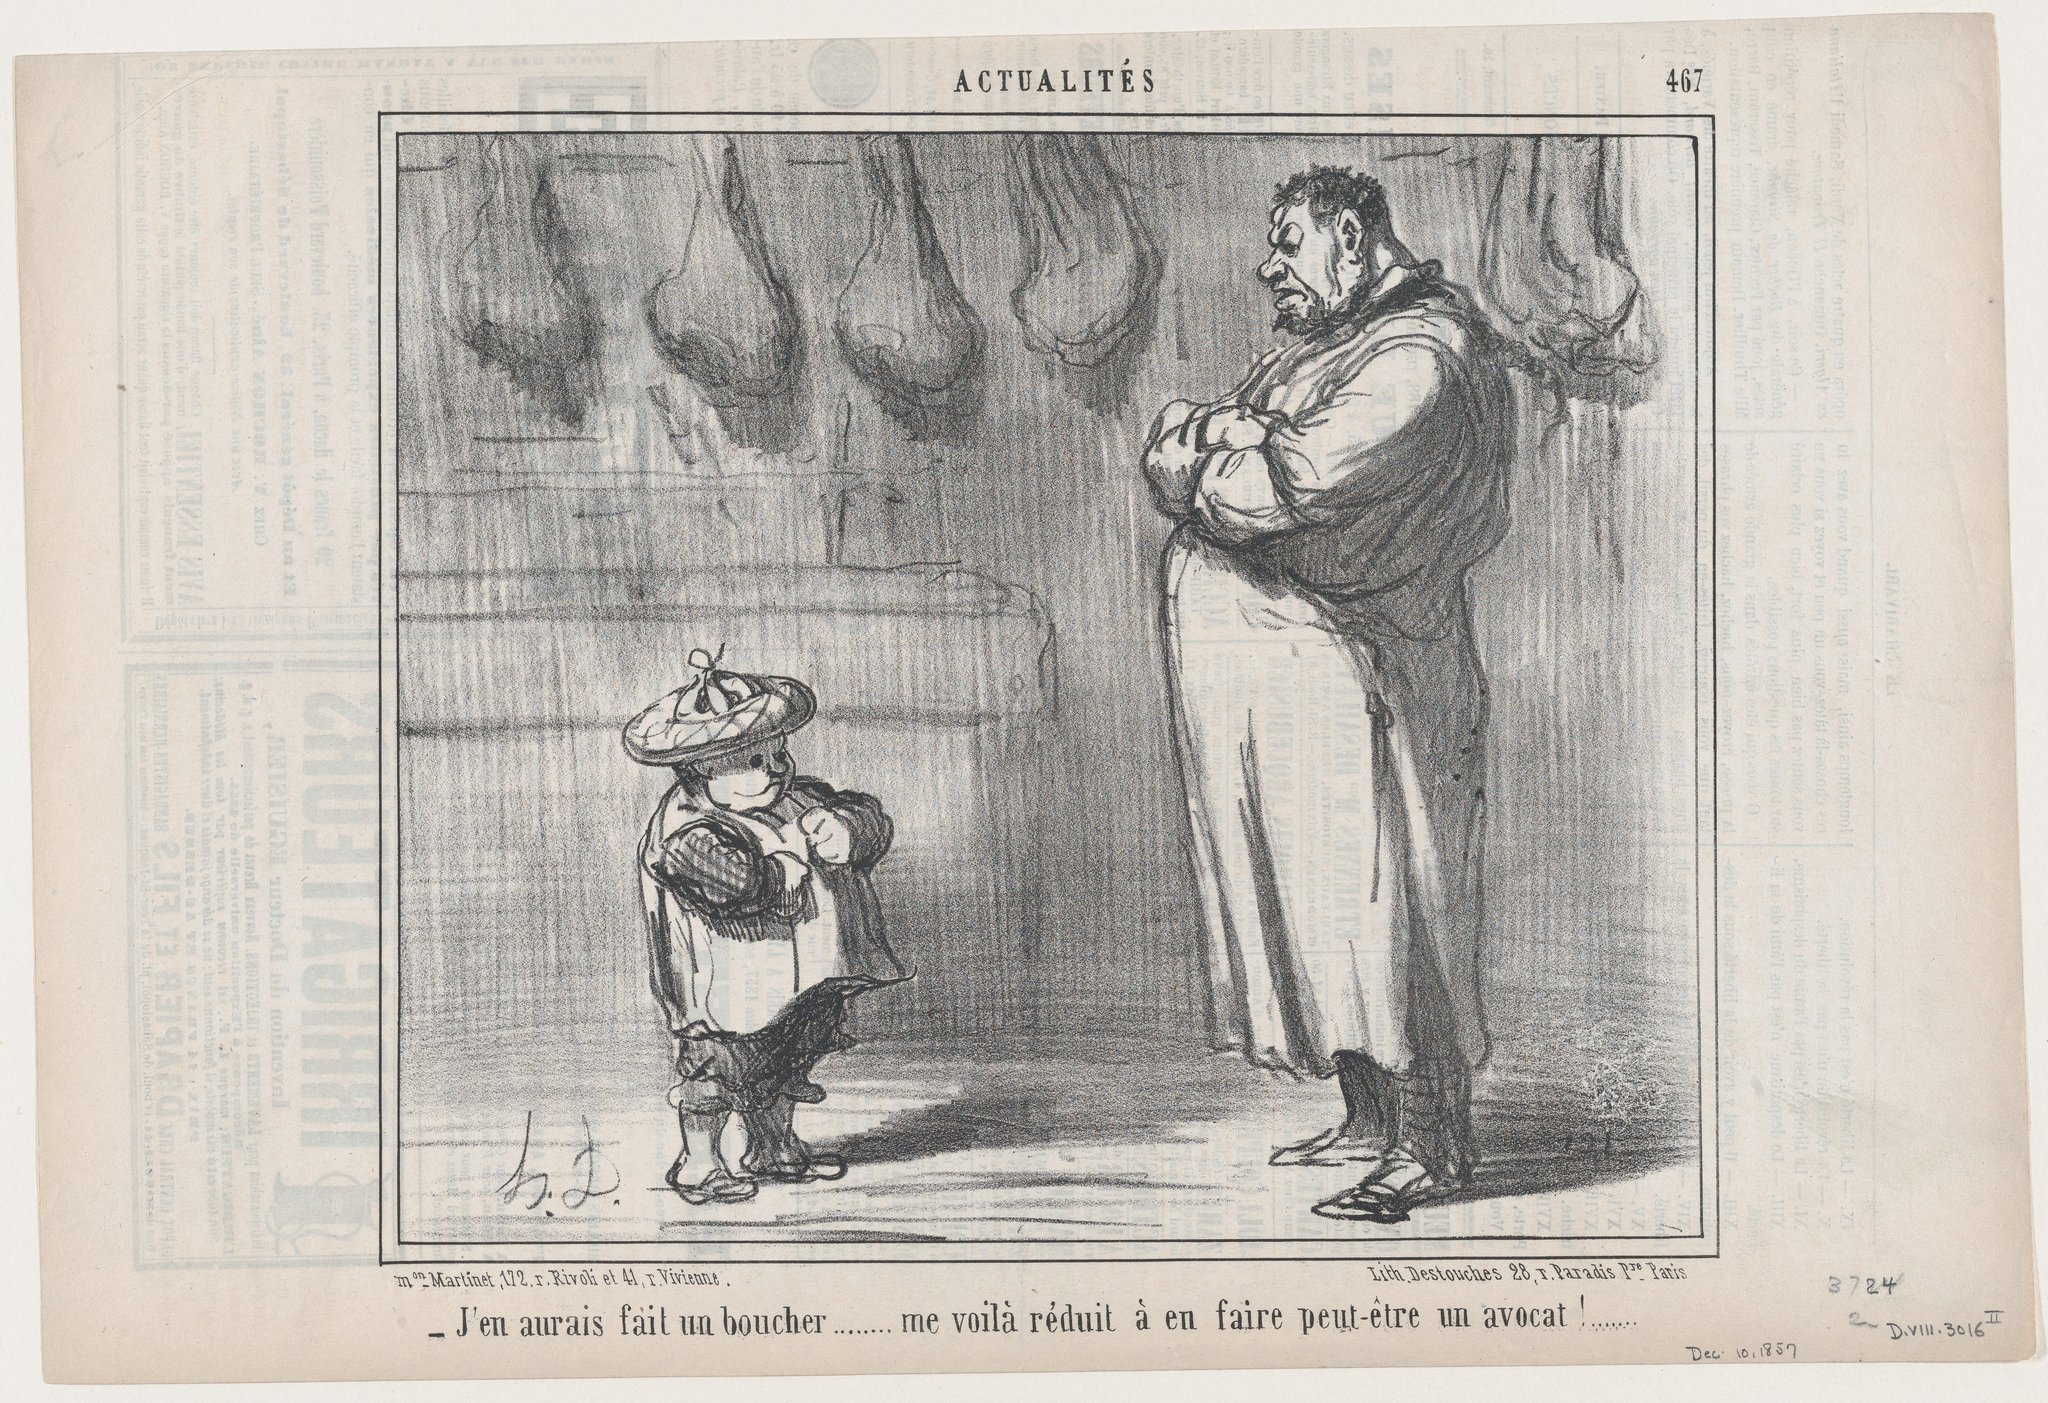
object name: print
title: J'en aurais fait un boucher..., from "Actualités"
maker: honoré daumier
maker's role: artist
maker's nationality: french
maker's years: 1808-1879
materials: paper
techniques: lithograph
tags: men